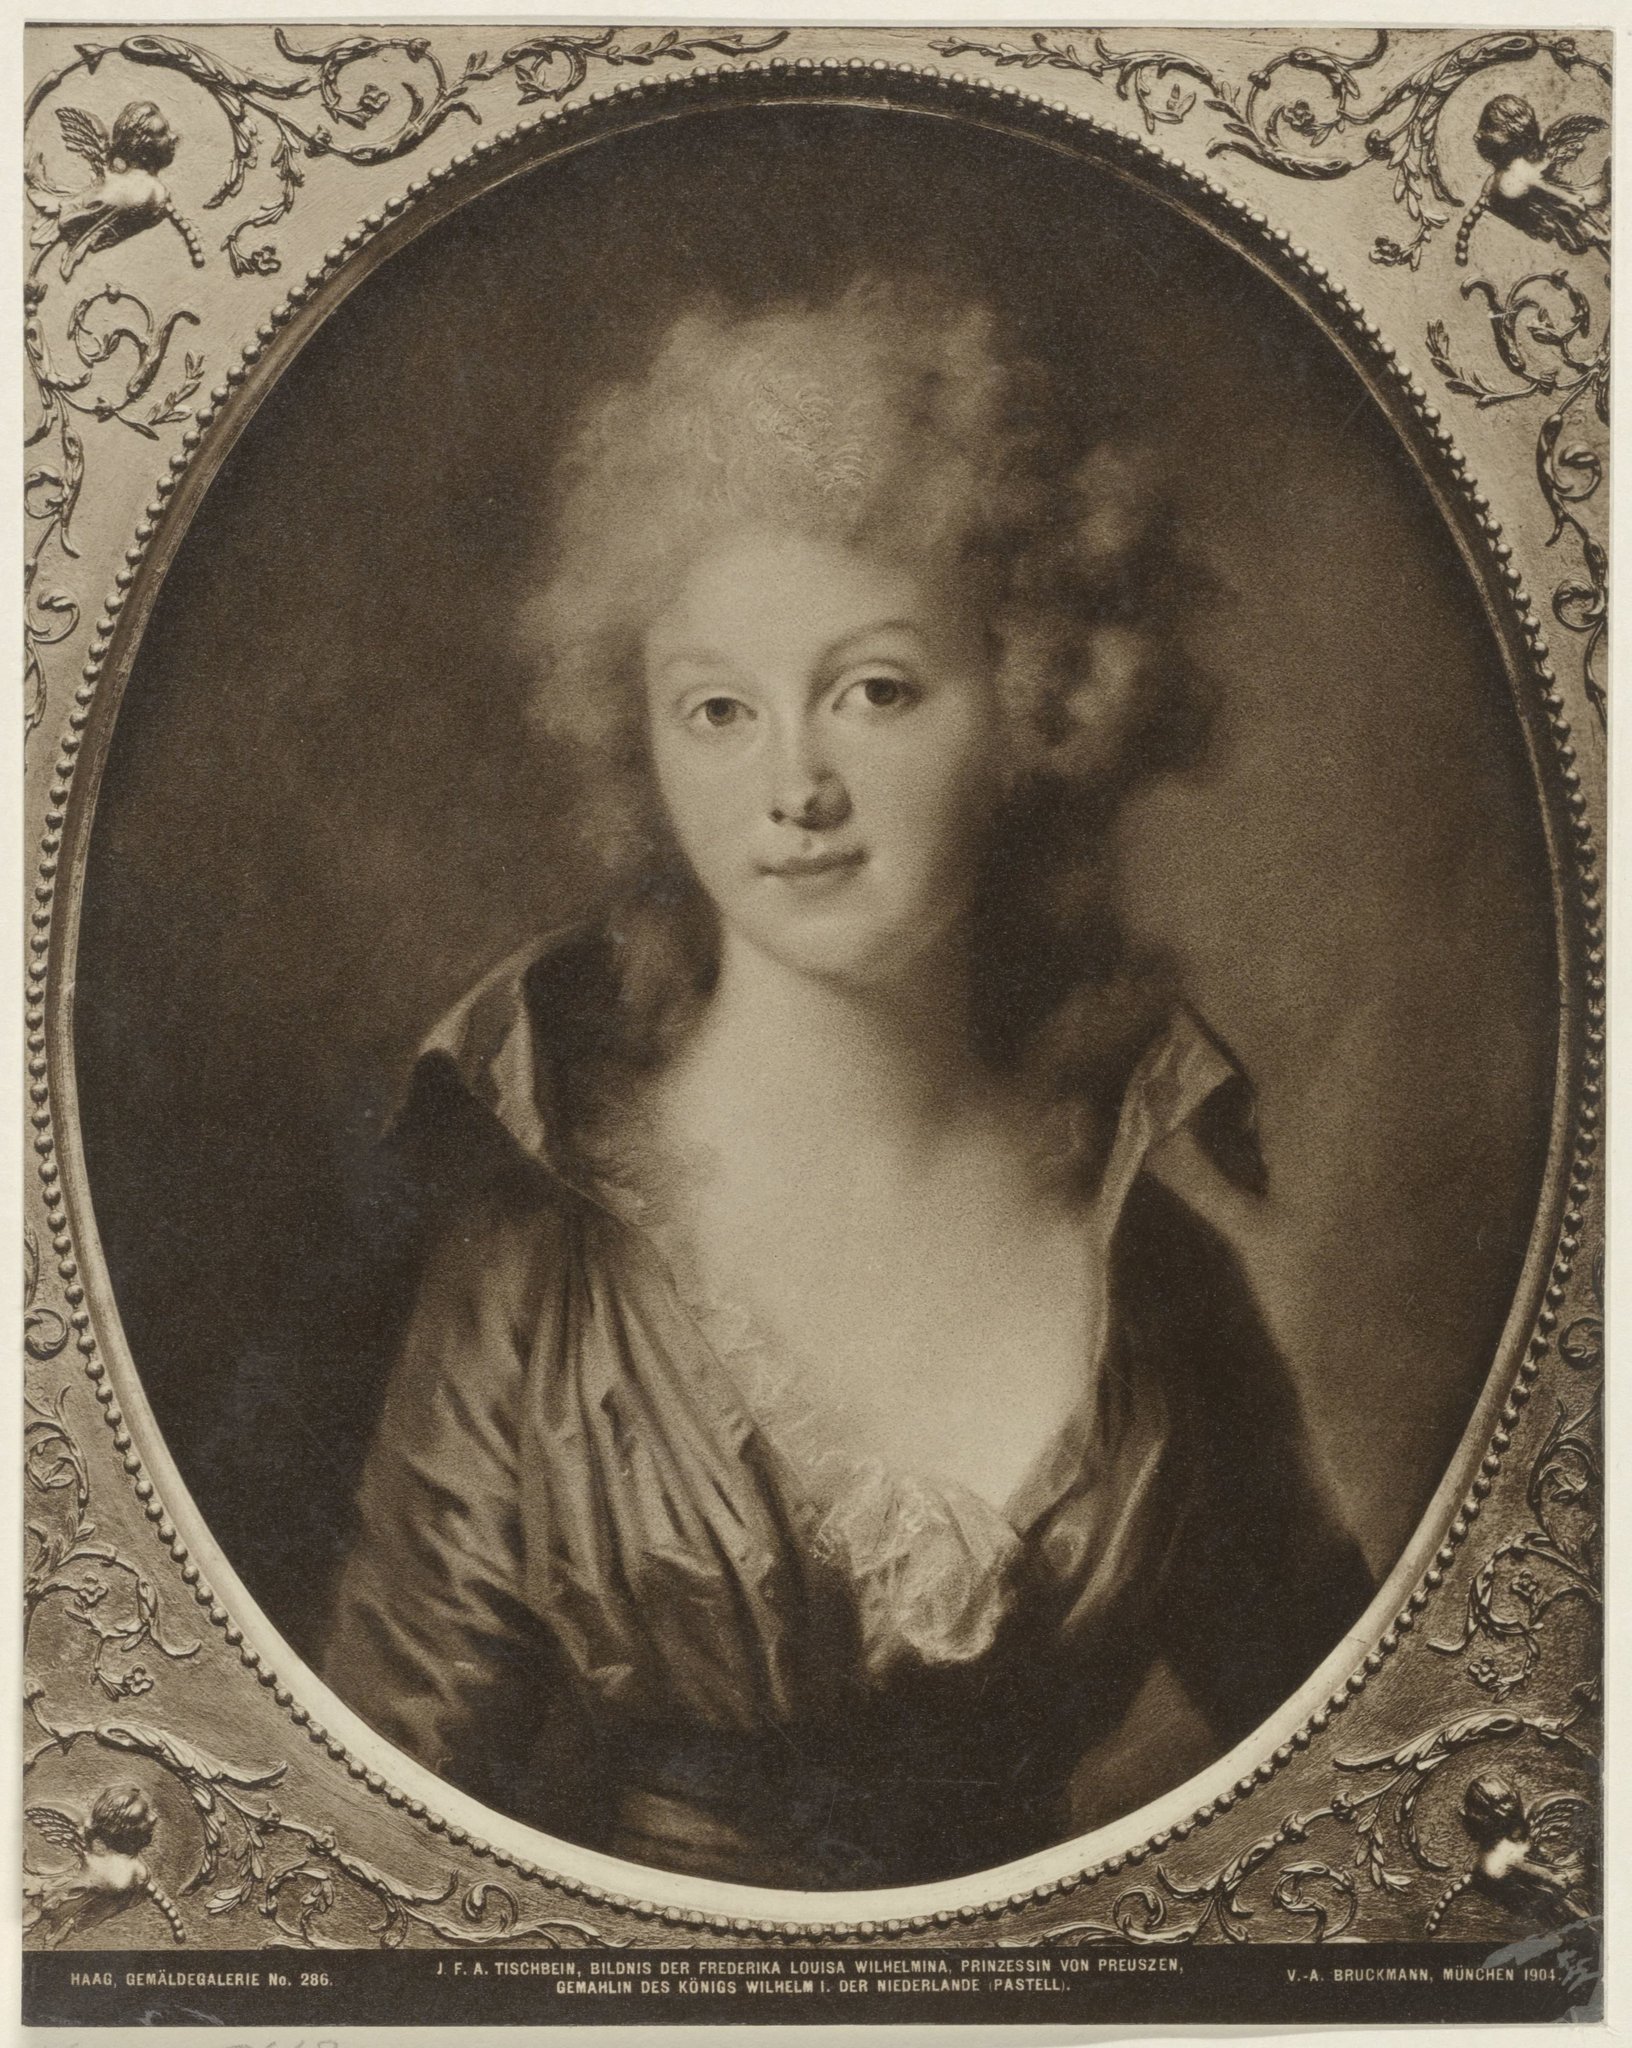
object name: photograph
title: Portret van Wilhelmina van Pruisen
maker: johann friedrich august tischbein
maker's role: painter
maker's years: 1750-1812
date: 1904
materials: photographic support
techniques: photography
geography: munich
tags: berlin, the hague, wilhelmina frederica louisa (koningin der nederlanden)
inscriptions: date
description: Portret van Wilhelmina in een ovaal. In de ondermarge haar naam en titels in het Duits.